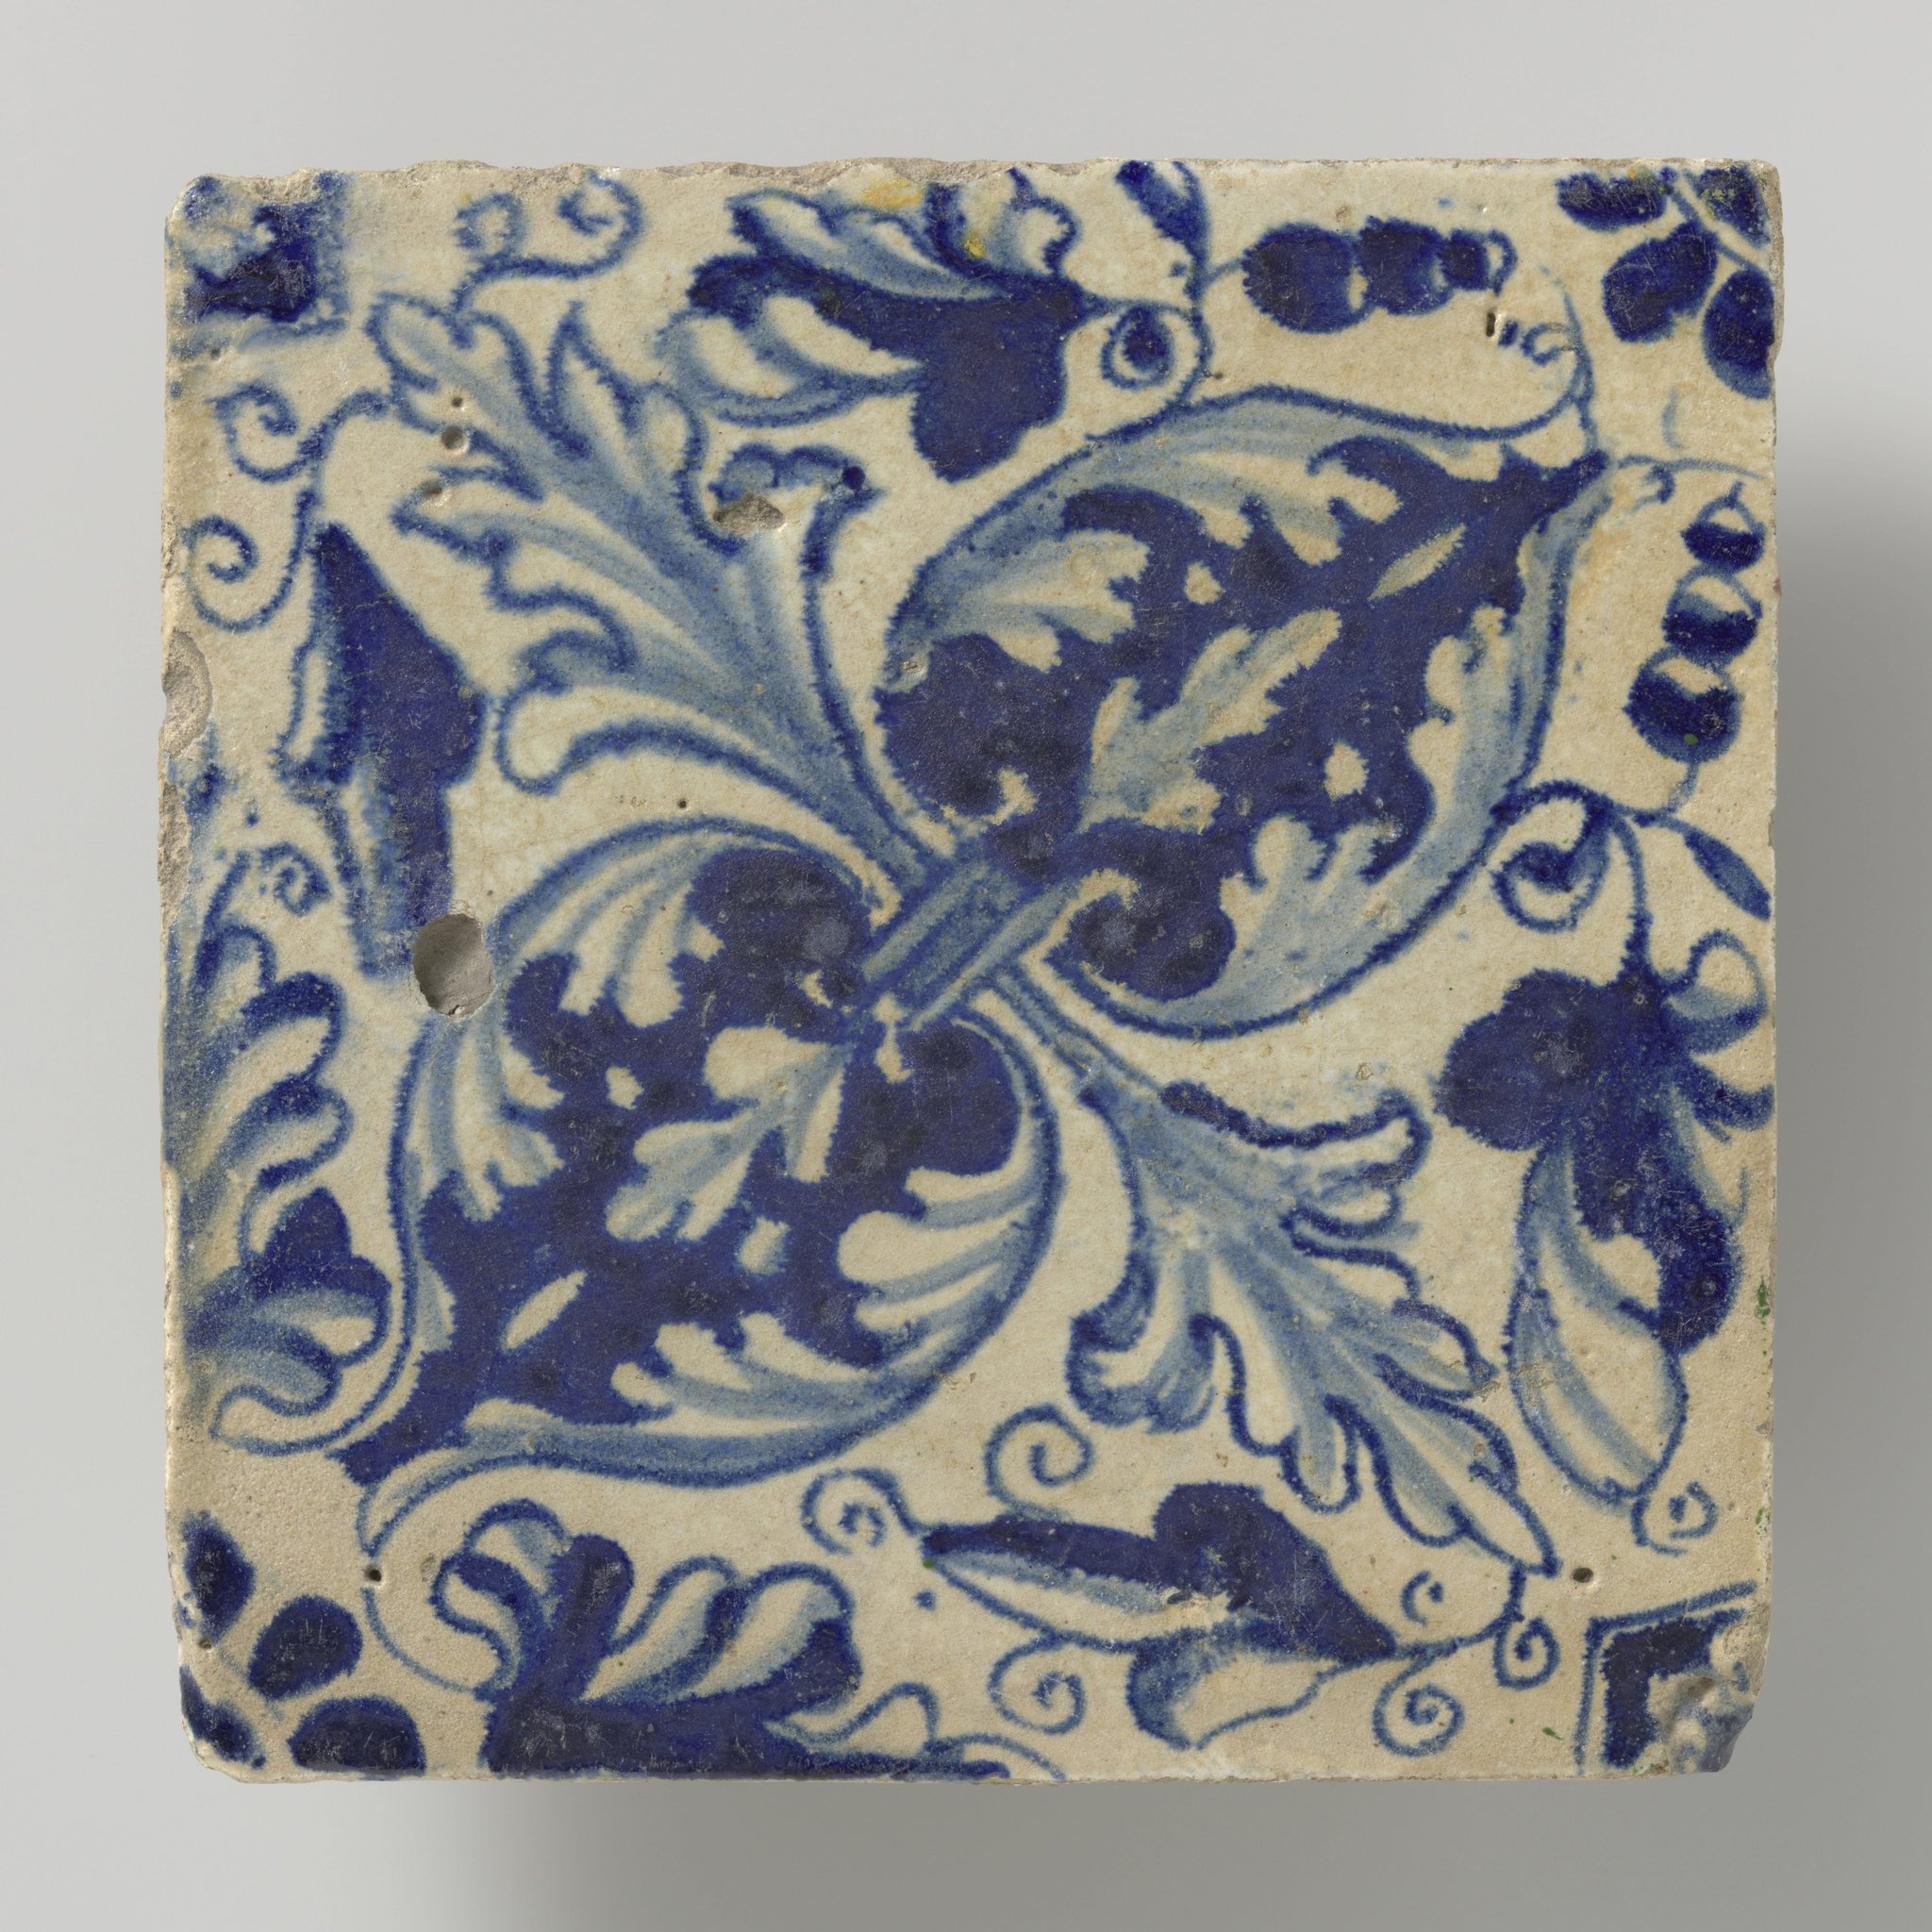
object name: tile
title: Tegel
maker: Anonymous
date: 1615-1625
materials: earthenware, glaze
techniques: maiolica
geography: netherlands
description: Tegel met blauw geschilderde bladpatronen van eikenblad, diagonaal geplaatst.